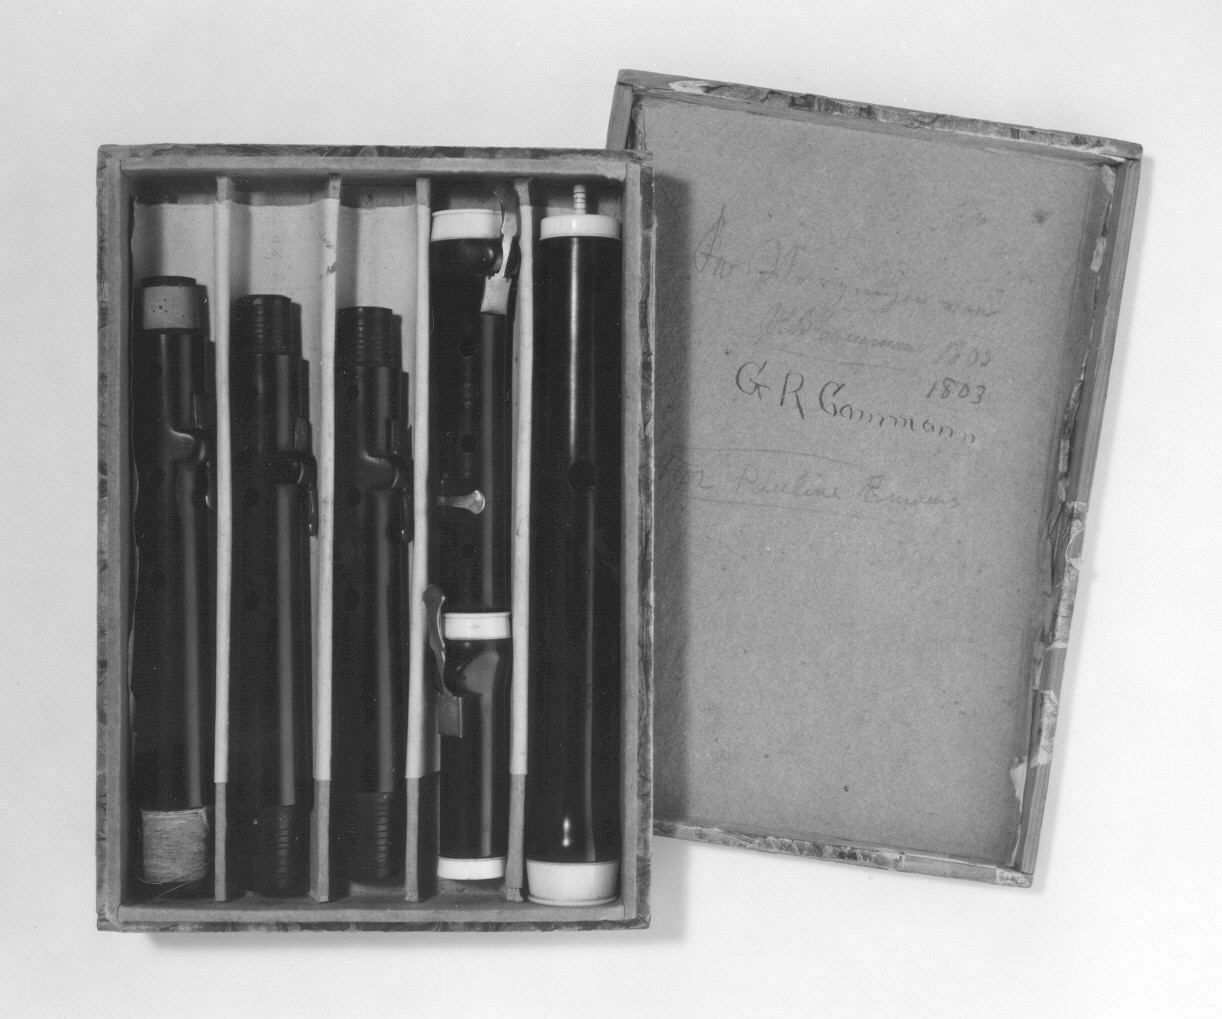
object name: transverse flute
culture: german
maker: johann friedrich boie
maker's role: maker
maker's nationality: german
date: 1800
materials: ivory, metal, silver, wood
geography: germany